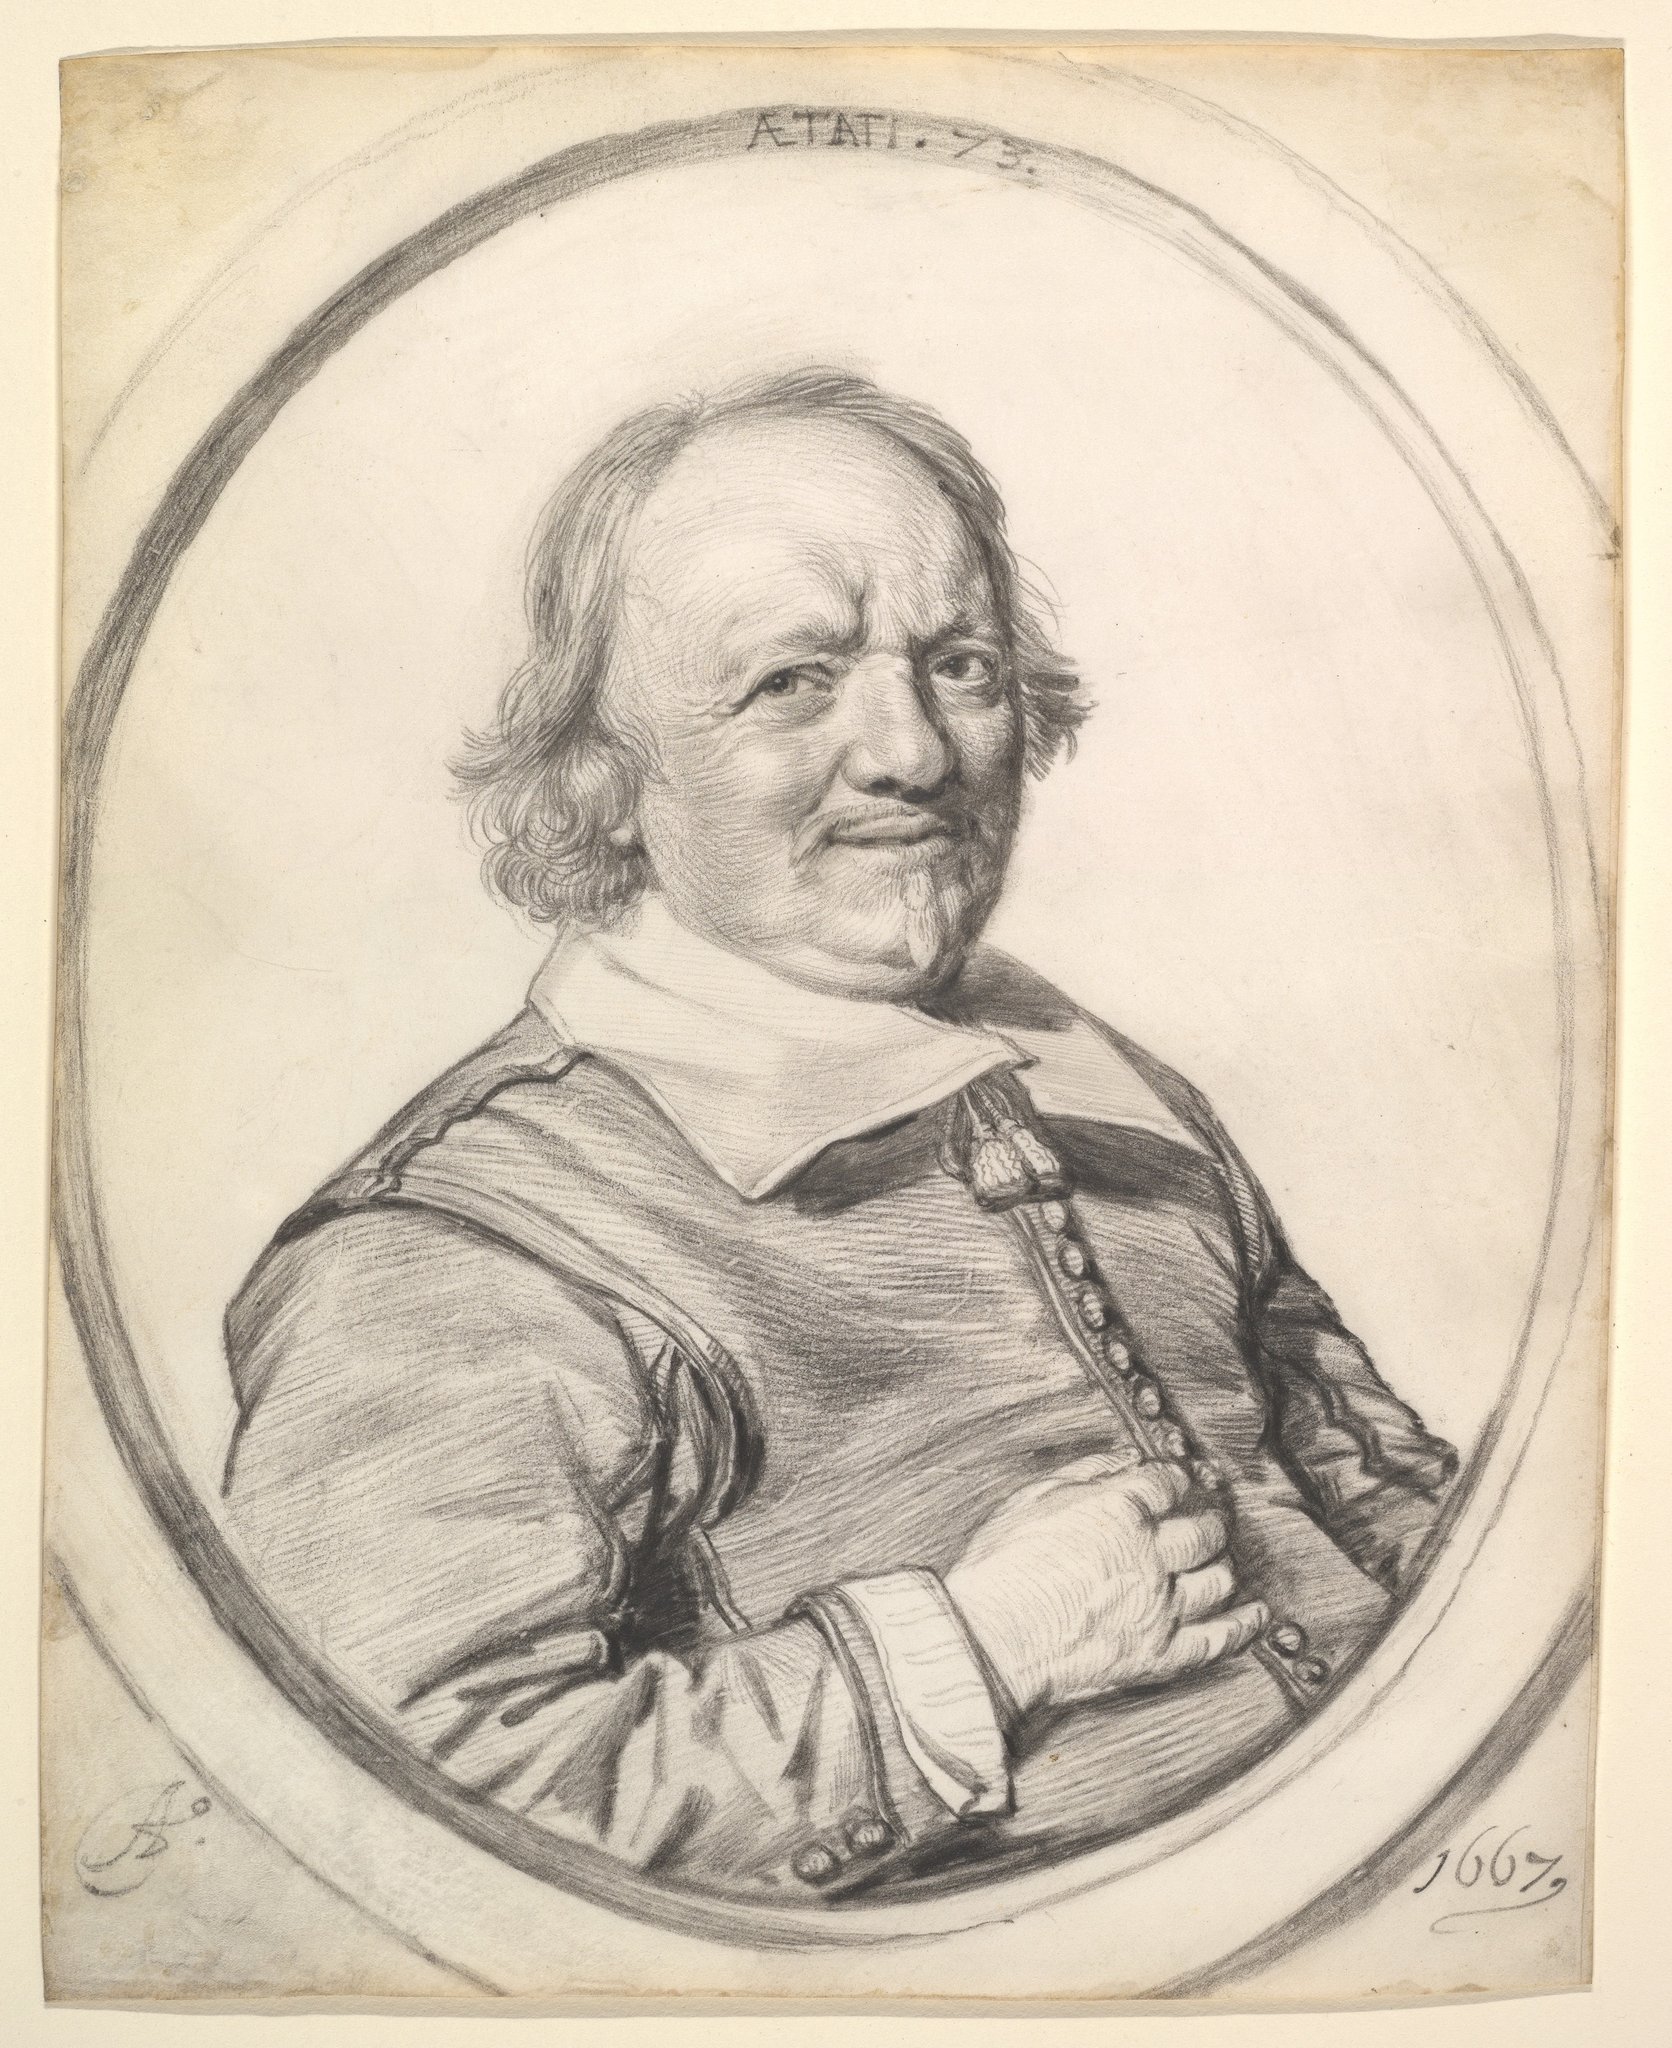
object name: drawing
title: Portrait of a Gentleman Aged 73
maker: anonymous, dutch, 17th century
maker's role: artist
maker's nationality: dutch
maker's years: 1600-1700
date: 1667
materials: chalk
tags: men,portraits